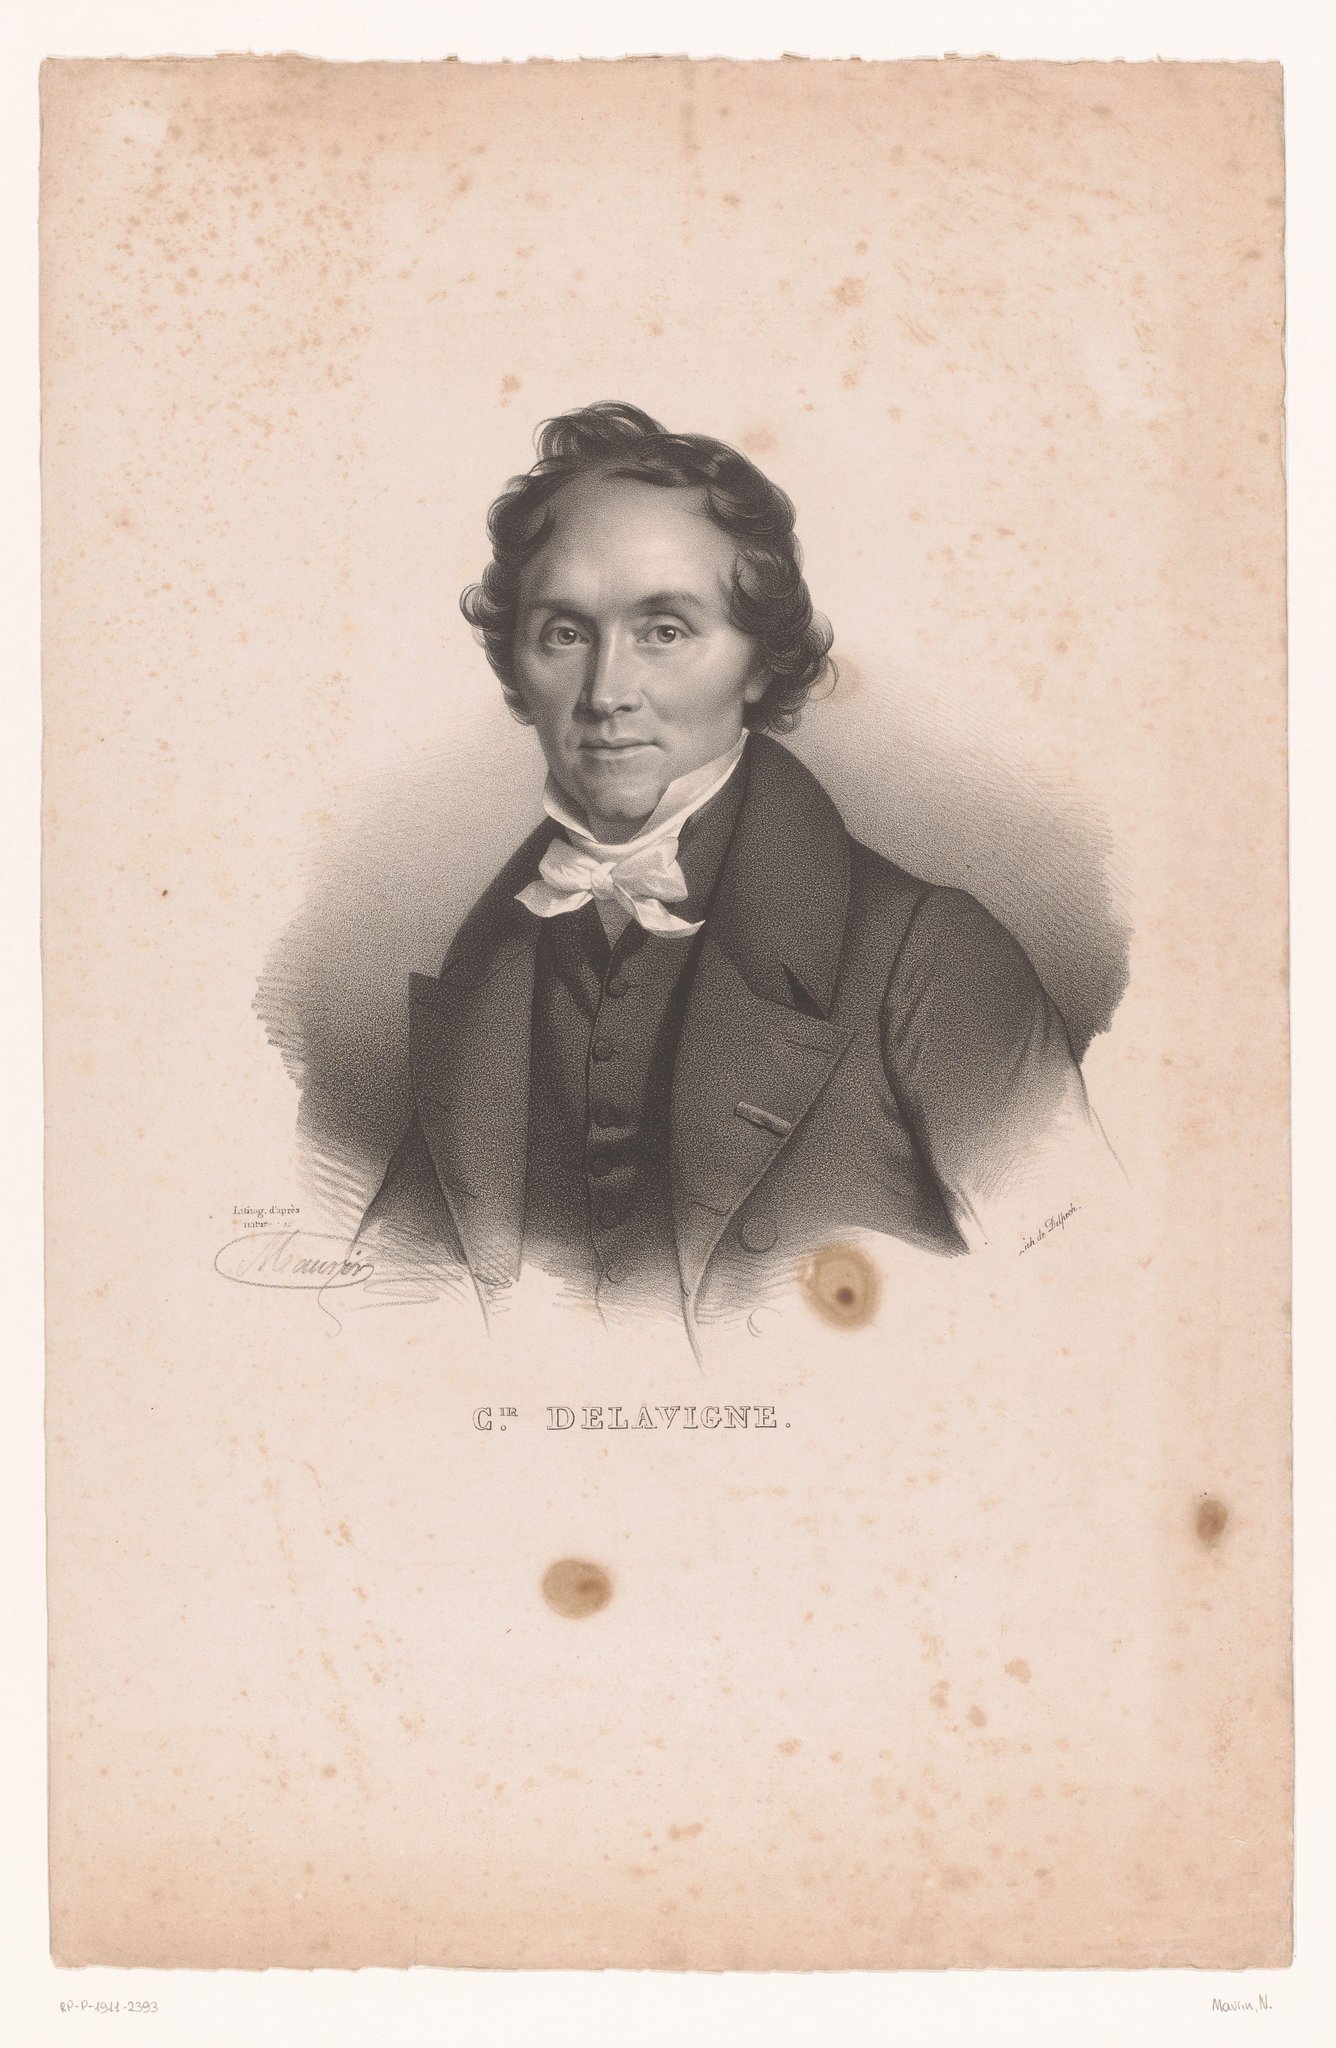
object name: print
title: Portret van Casimir Delavigne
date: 1825-1842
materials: paper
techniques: lithograph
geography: paris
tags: historical persons, writer, poet, author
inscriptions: collector's mark: Lugt 2228